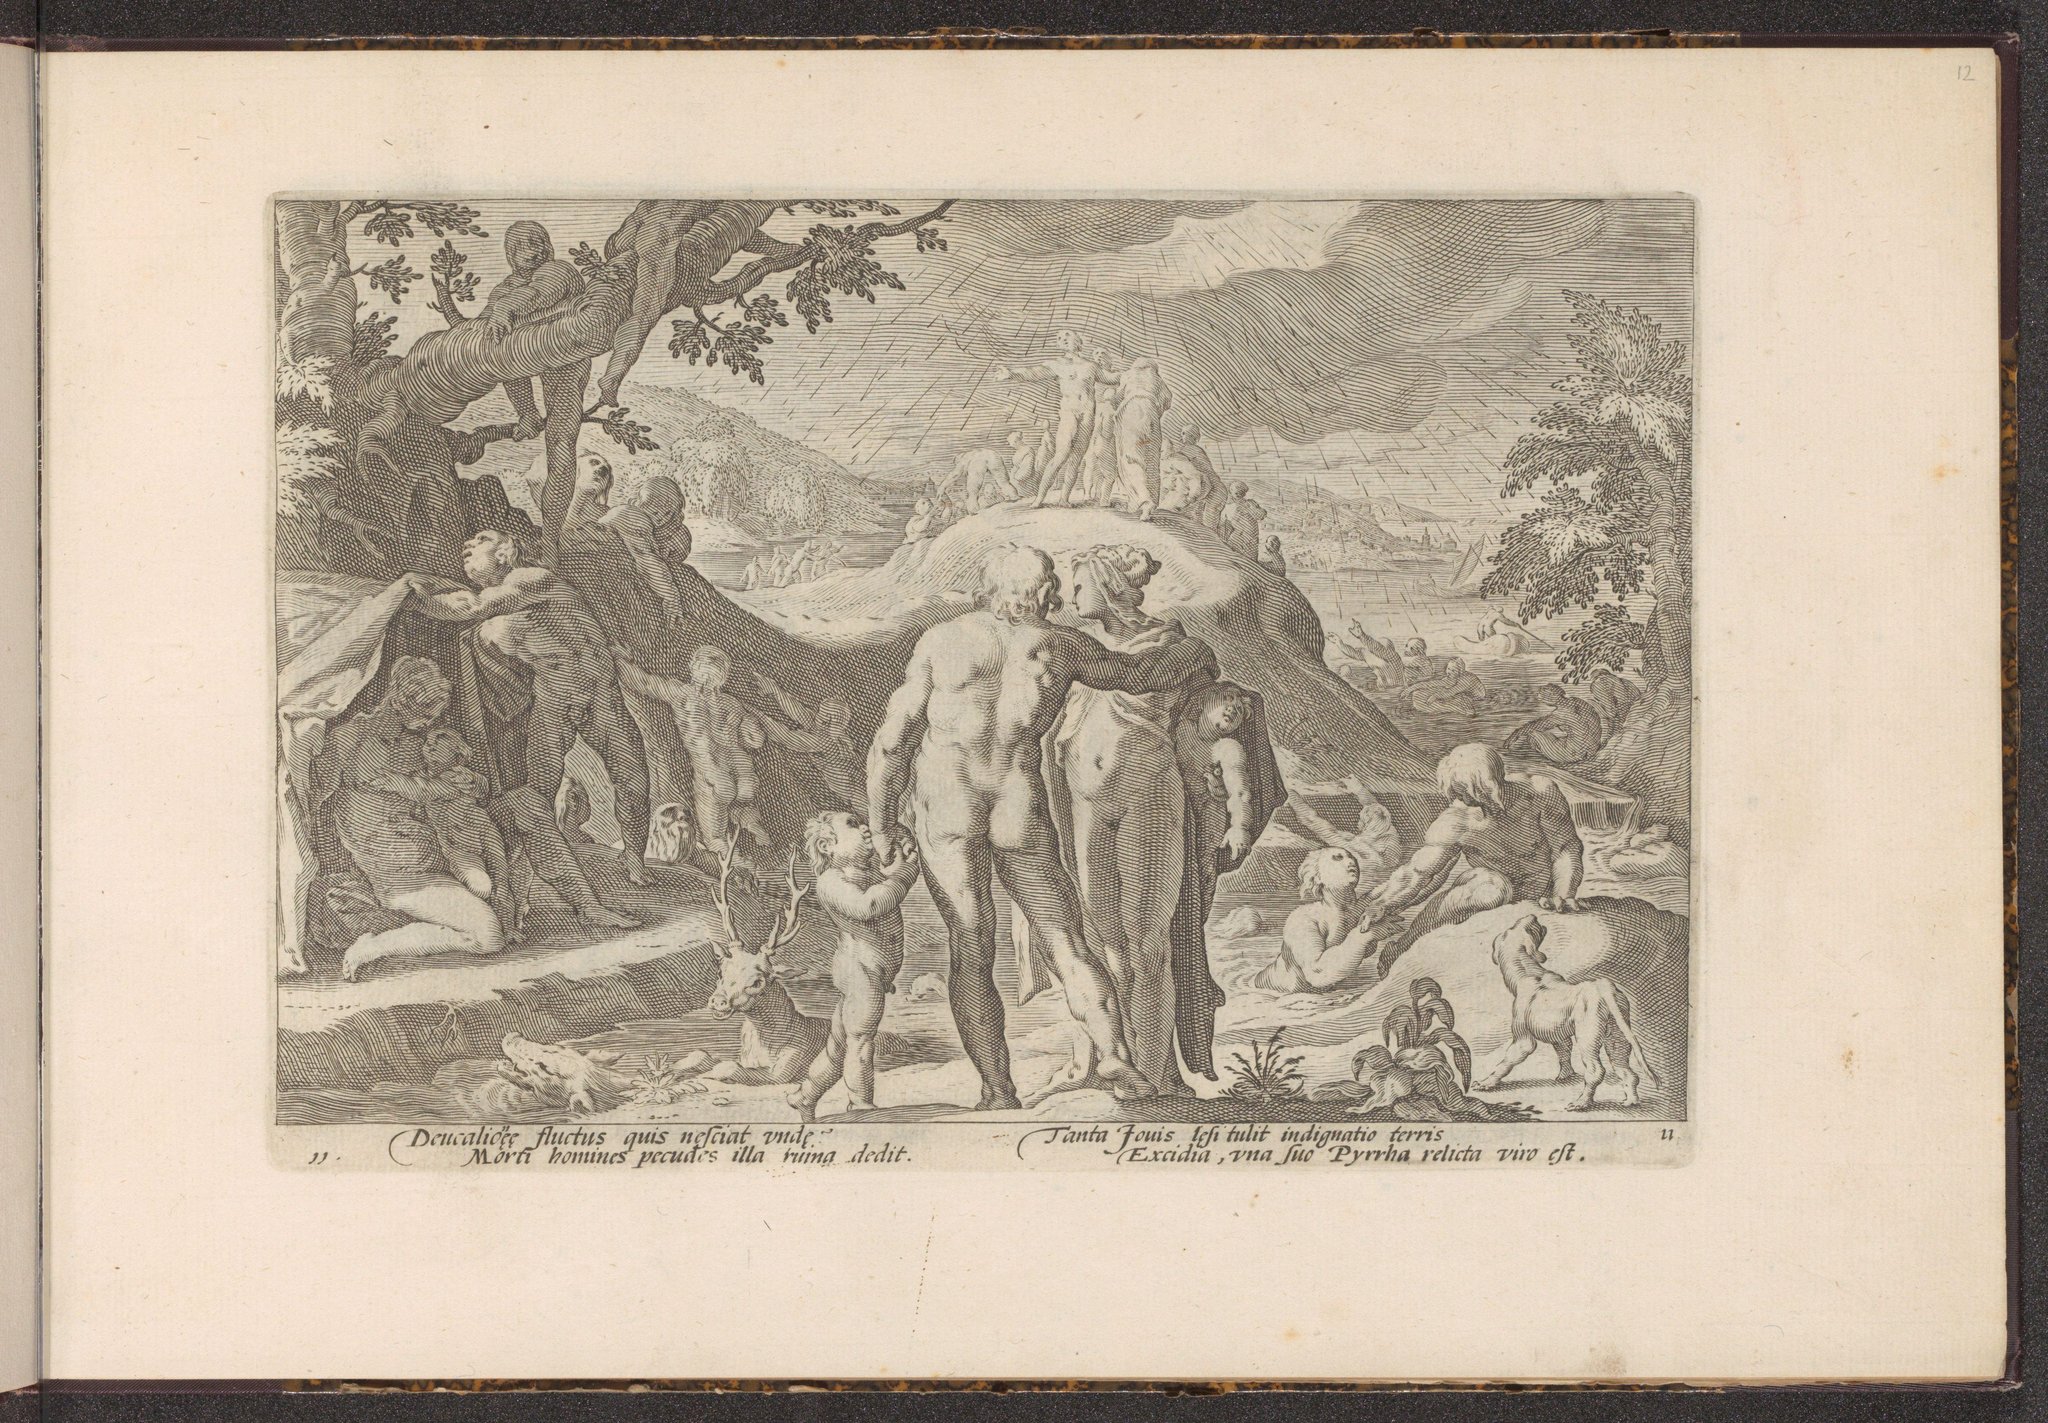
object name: print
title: Herscheppingen van P. Ovidius Naso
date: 1589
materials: paper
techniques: engraving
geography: haarlem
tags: deucalion's flood; jupiter sends a great flood to destroy mankind; deucalion and pyrrha afloat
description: In een bergachtig kustlandschap worden mensen en dieren getroffen door een zondvloed. Ze zoeken een veilig heenkomen op hoger gelegen plaatsen. Twee mannen klimmen in een boom. Vooraan een man en vrouw en hun twee kinderen. Links een everzwijn en hert. Rechts een hond. Onder de voorstelling twee keer twee versregels in het Latijn. De prent maakt deel uit van een album.